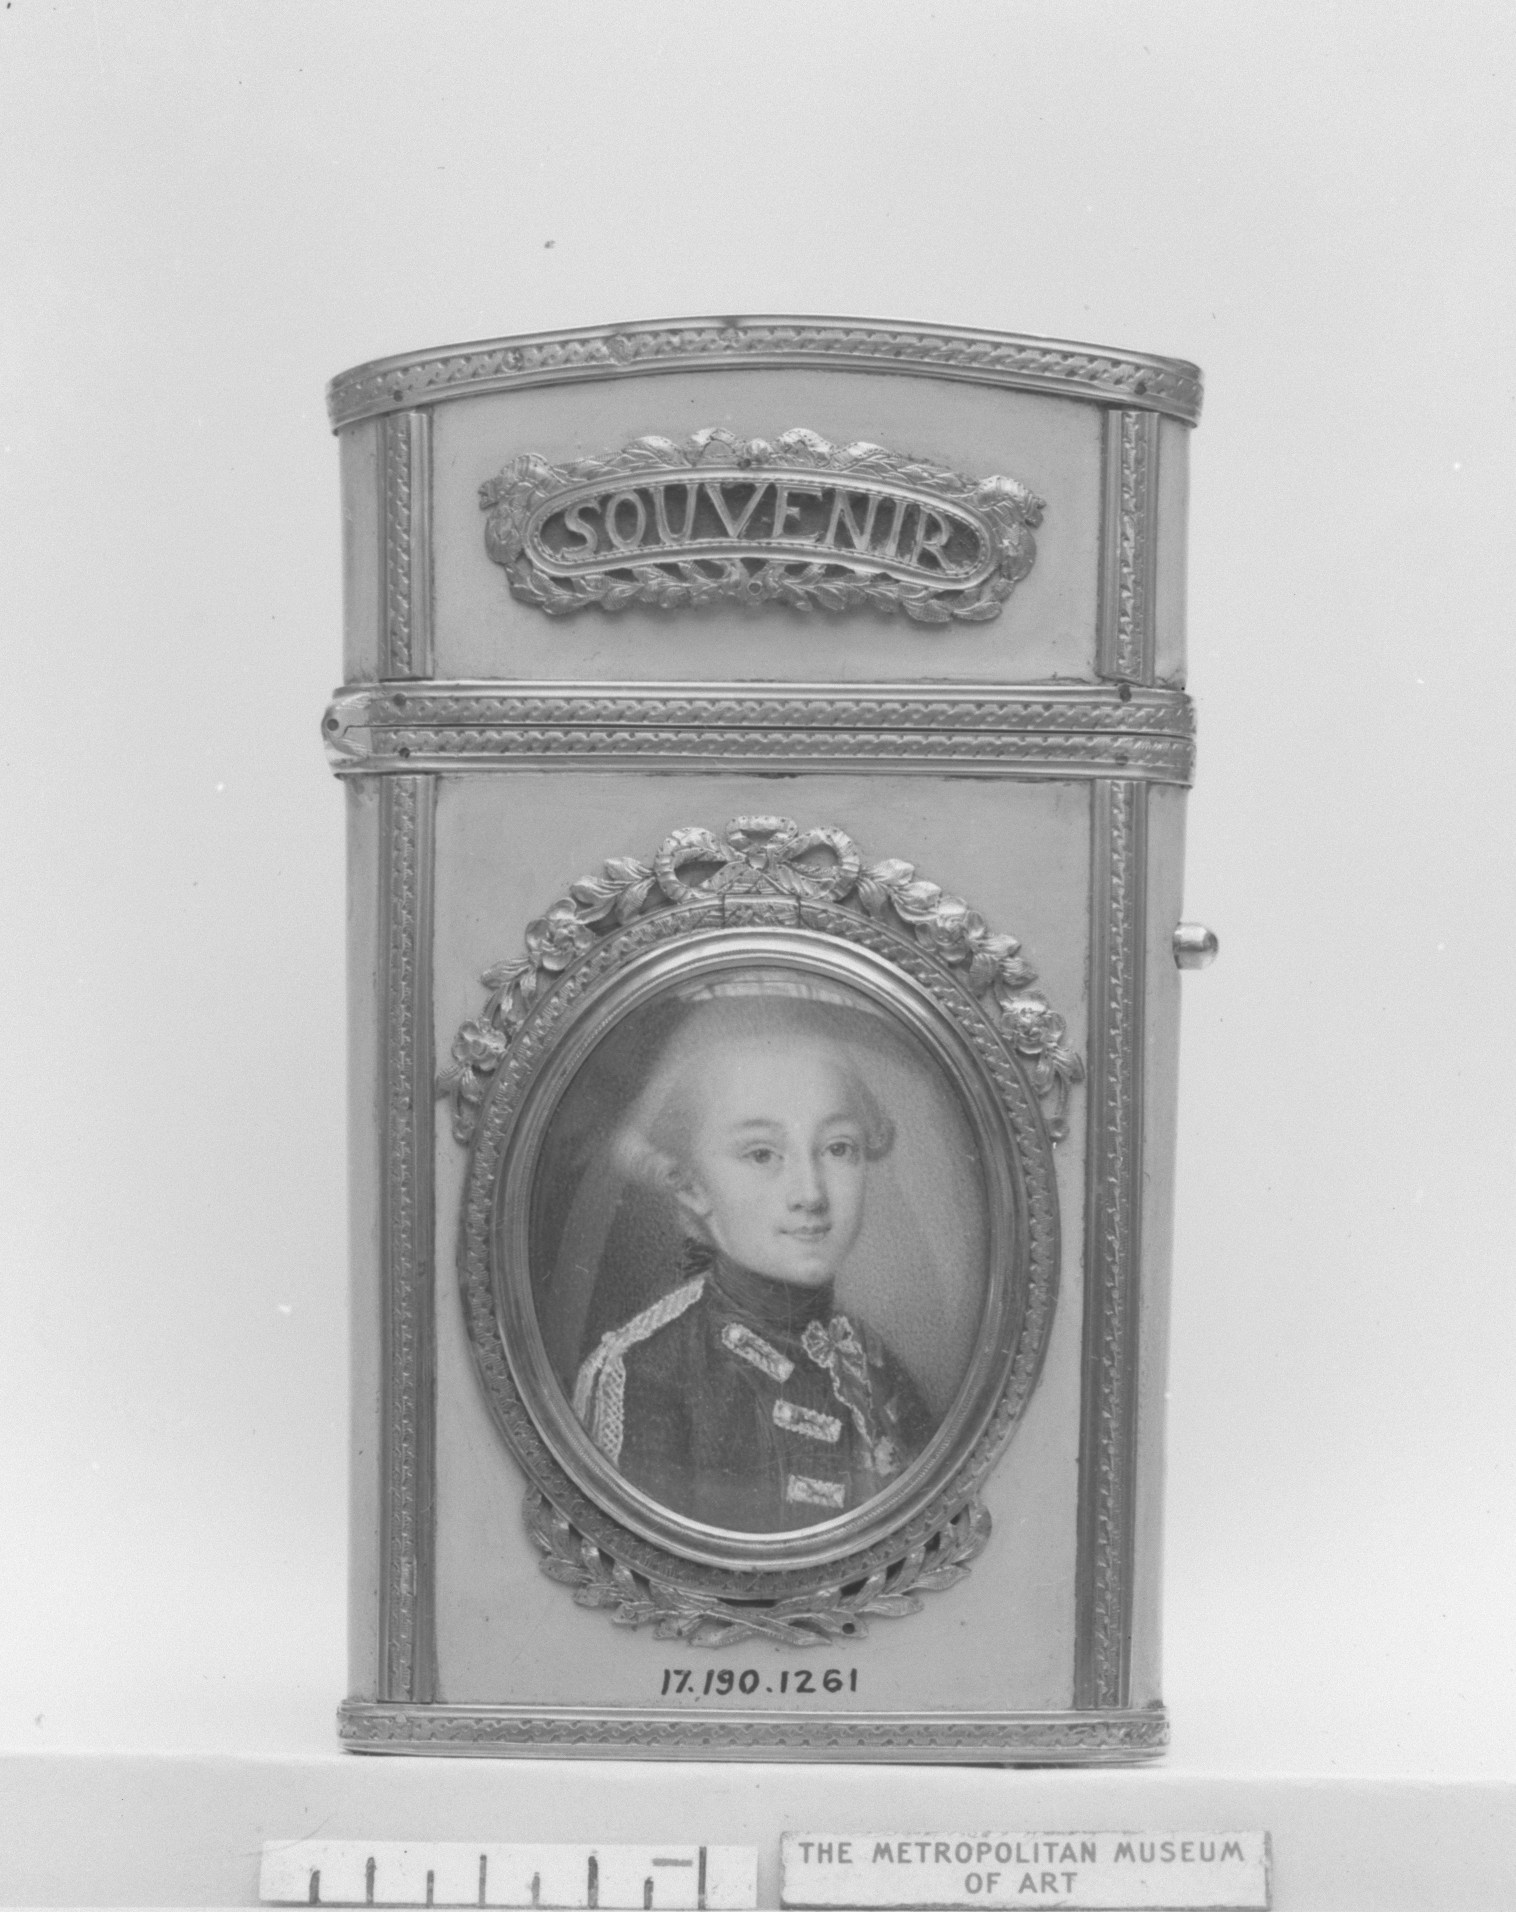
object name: souvenir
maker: c. b.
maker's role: maker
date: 1769-1770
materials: gold, ivory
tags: men,portraits